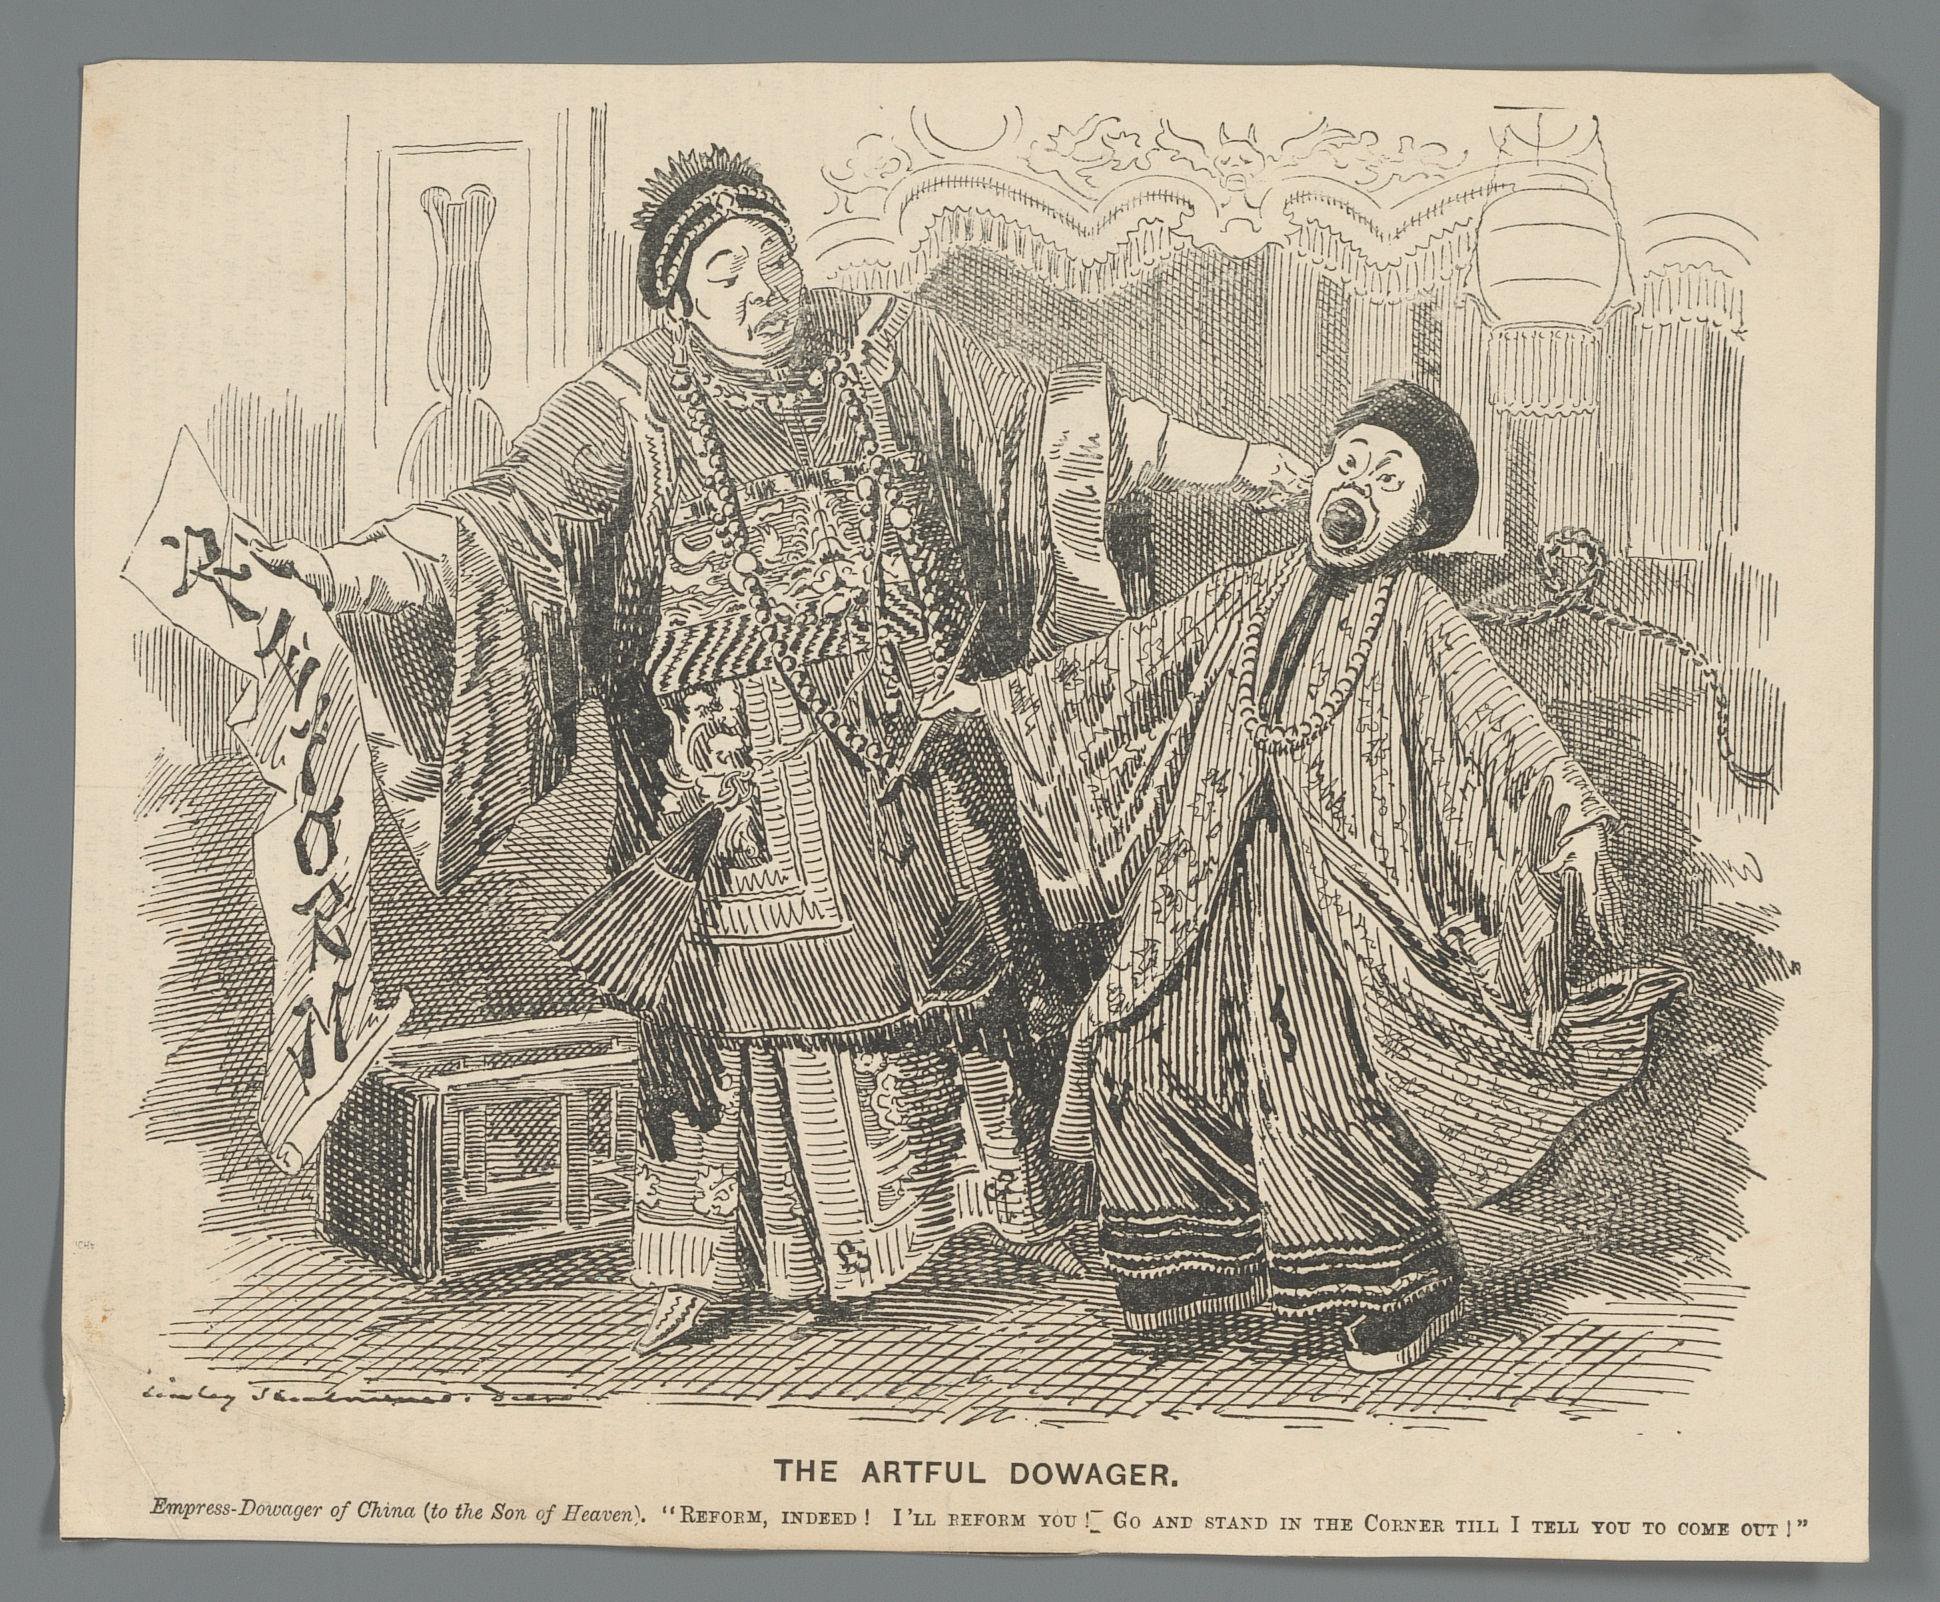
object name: cartoon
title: The artful dowager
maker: edward linley sambourne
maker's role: draughtsman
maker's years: 1844-1910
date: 1898-1899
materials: paper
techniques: line block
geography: england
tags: personifications of countries, nations, states, districts, etc., political caricatures and satires, china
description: Spotprent op de hervormingen in China. Een moeder geeft haar zoon bestraffend een draai om de oren. Spotprent uit het Engelse satirische tijdschrift Punch, ca. 1898-1899.